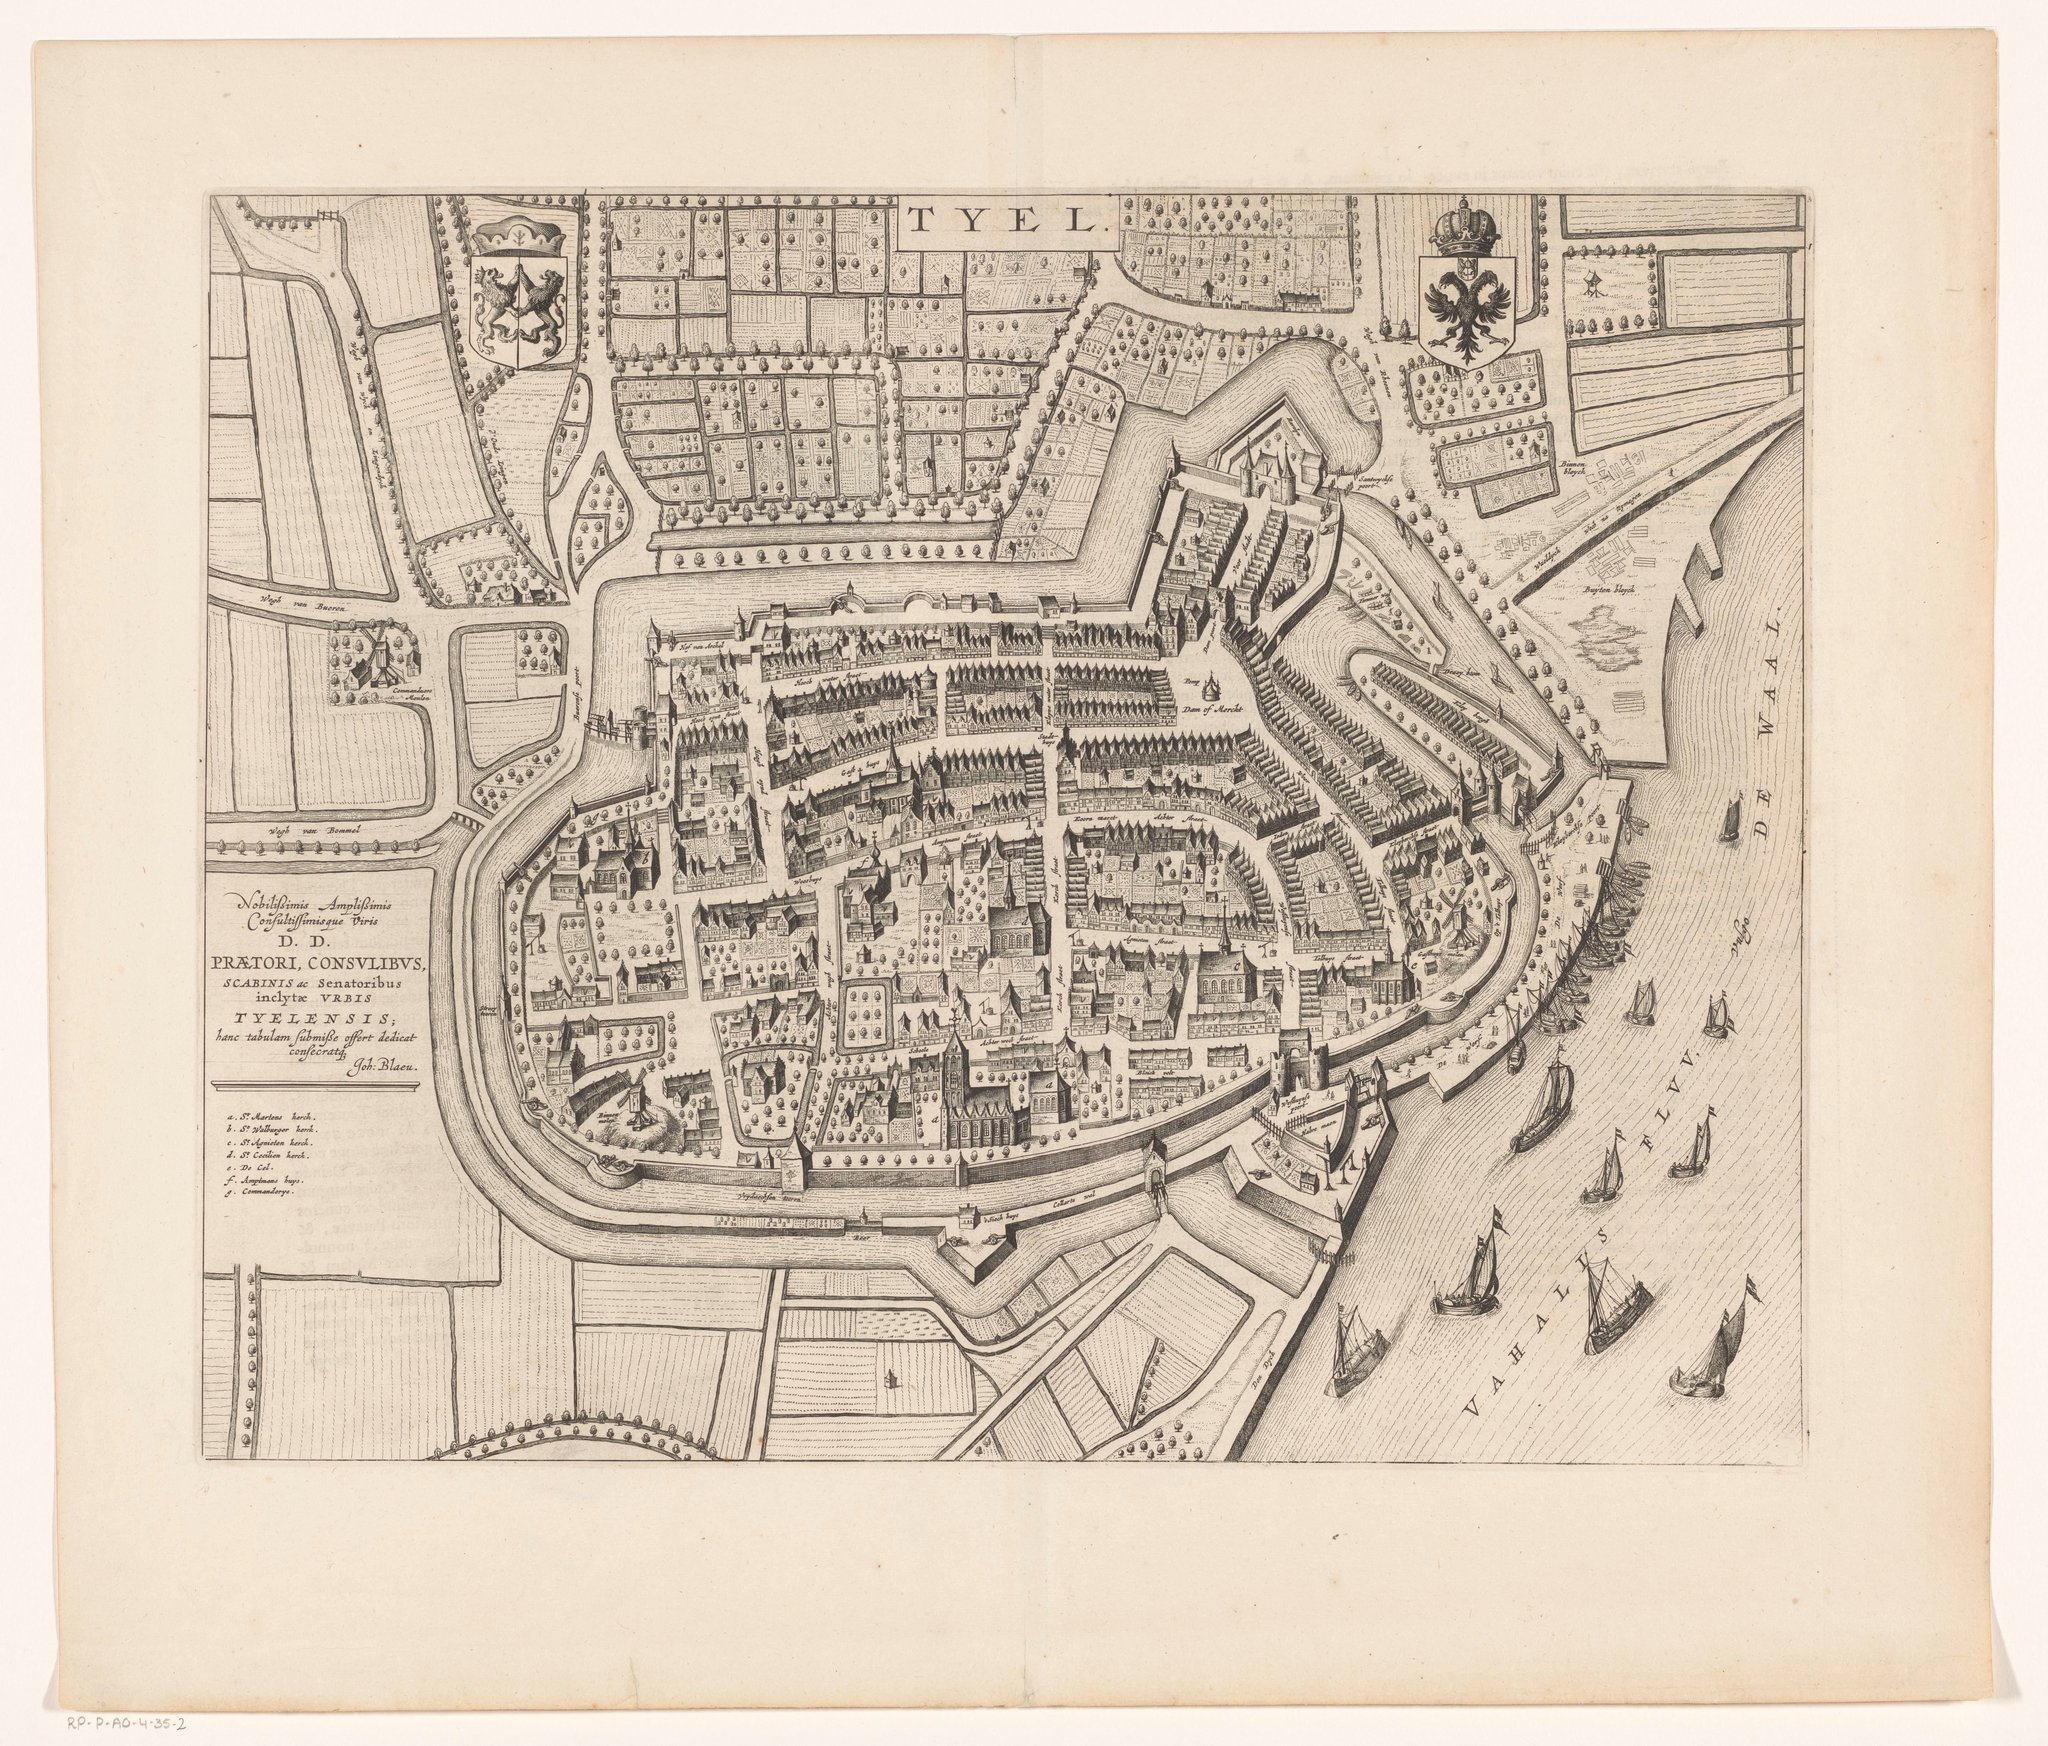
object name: print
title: Tyel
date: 1652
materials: paper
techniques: engraving, etching, letterpress printing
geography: amsterdam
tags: coat of arms (as symbol of the state, etc.), maps of cities, gelderland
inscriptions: collector's mark: Lugt 2233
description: Plattegrond in vogelvluchtperspectief. Linksboven het wapen van Gelderland. Links de opdracht met daaronder de legenda. Rechtsboven het wapen van Tiel. Op verso Latijnse tekst.